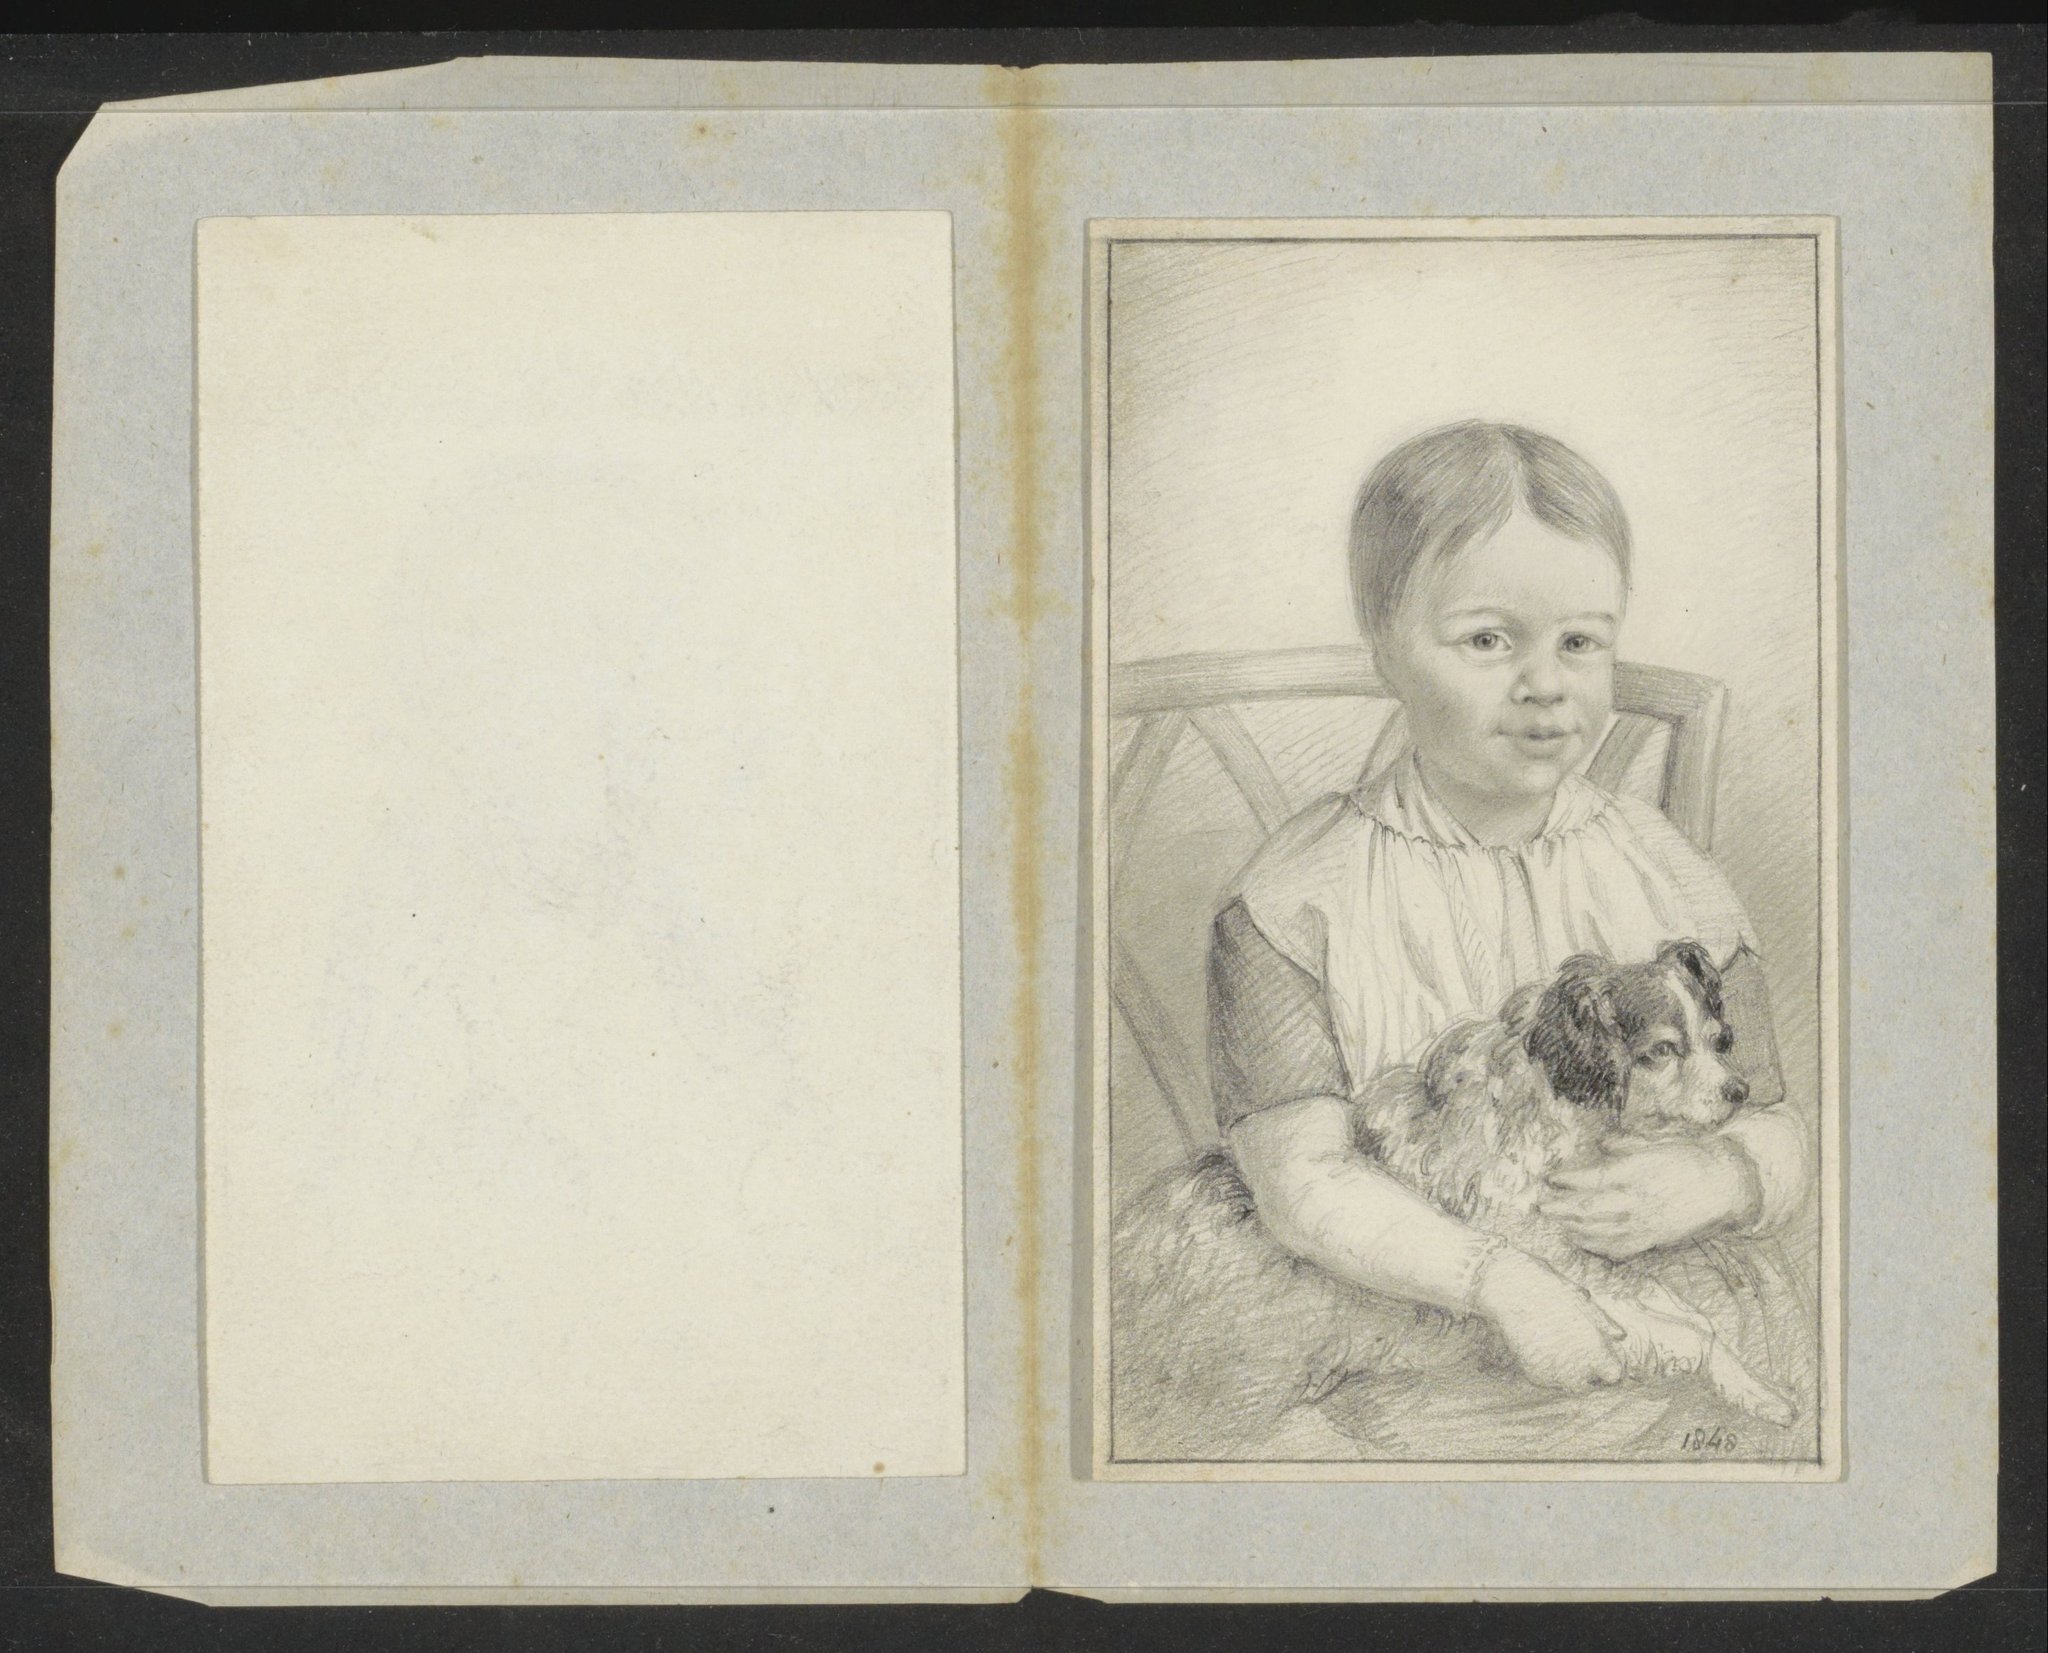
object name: sketchbook leaf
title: Portret van Lucia Steuerwald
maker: christian heinrich gottlieb steuerwald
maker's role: draughtsman, print maker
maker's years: 1802-1874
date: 1848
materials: paper, pencil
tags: historical persons (portraits and scenes from the life), dog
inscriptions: date: ‘48’, name: ‘LUCIA Steuerwald’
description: Het meisje zit op een stoel en heeft een hond op schoot. Tekening in een kader. Losse tekening tussen blad 61 en het achterste schutblad uit een schetsboek met 61 bladen.